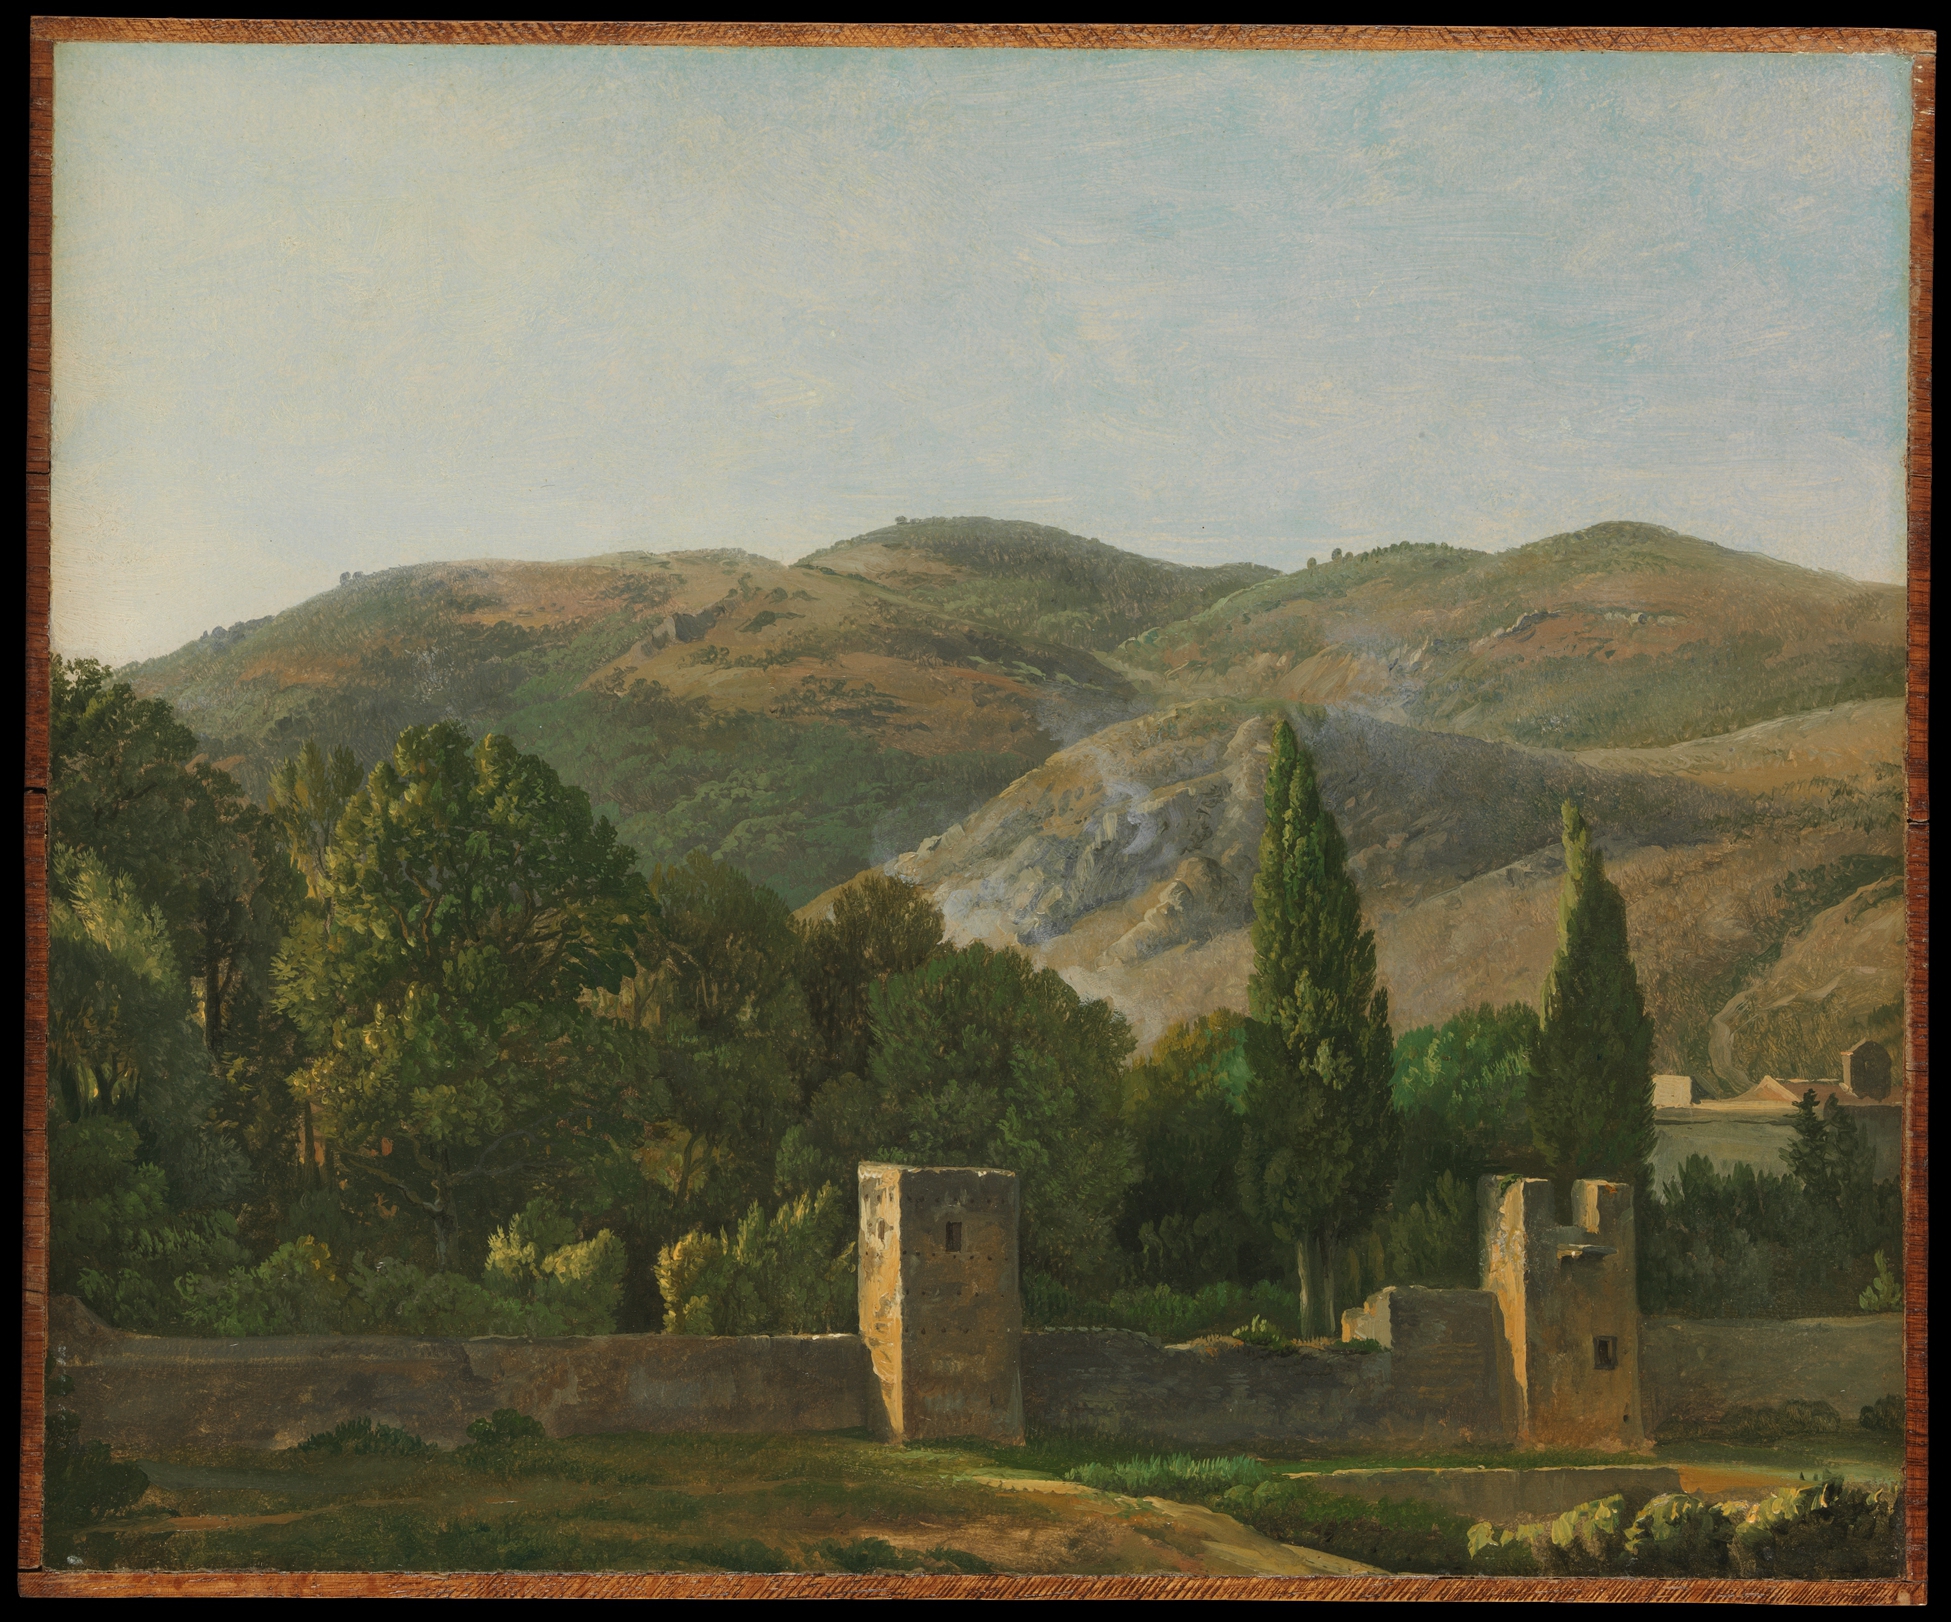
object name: painting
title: Fortified Wall at Tivoli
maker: simon denis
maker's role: artist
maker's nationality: flemish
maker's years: 1755-1813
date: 1786-1806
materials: oil, paper, wood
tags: mountains,landscapes